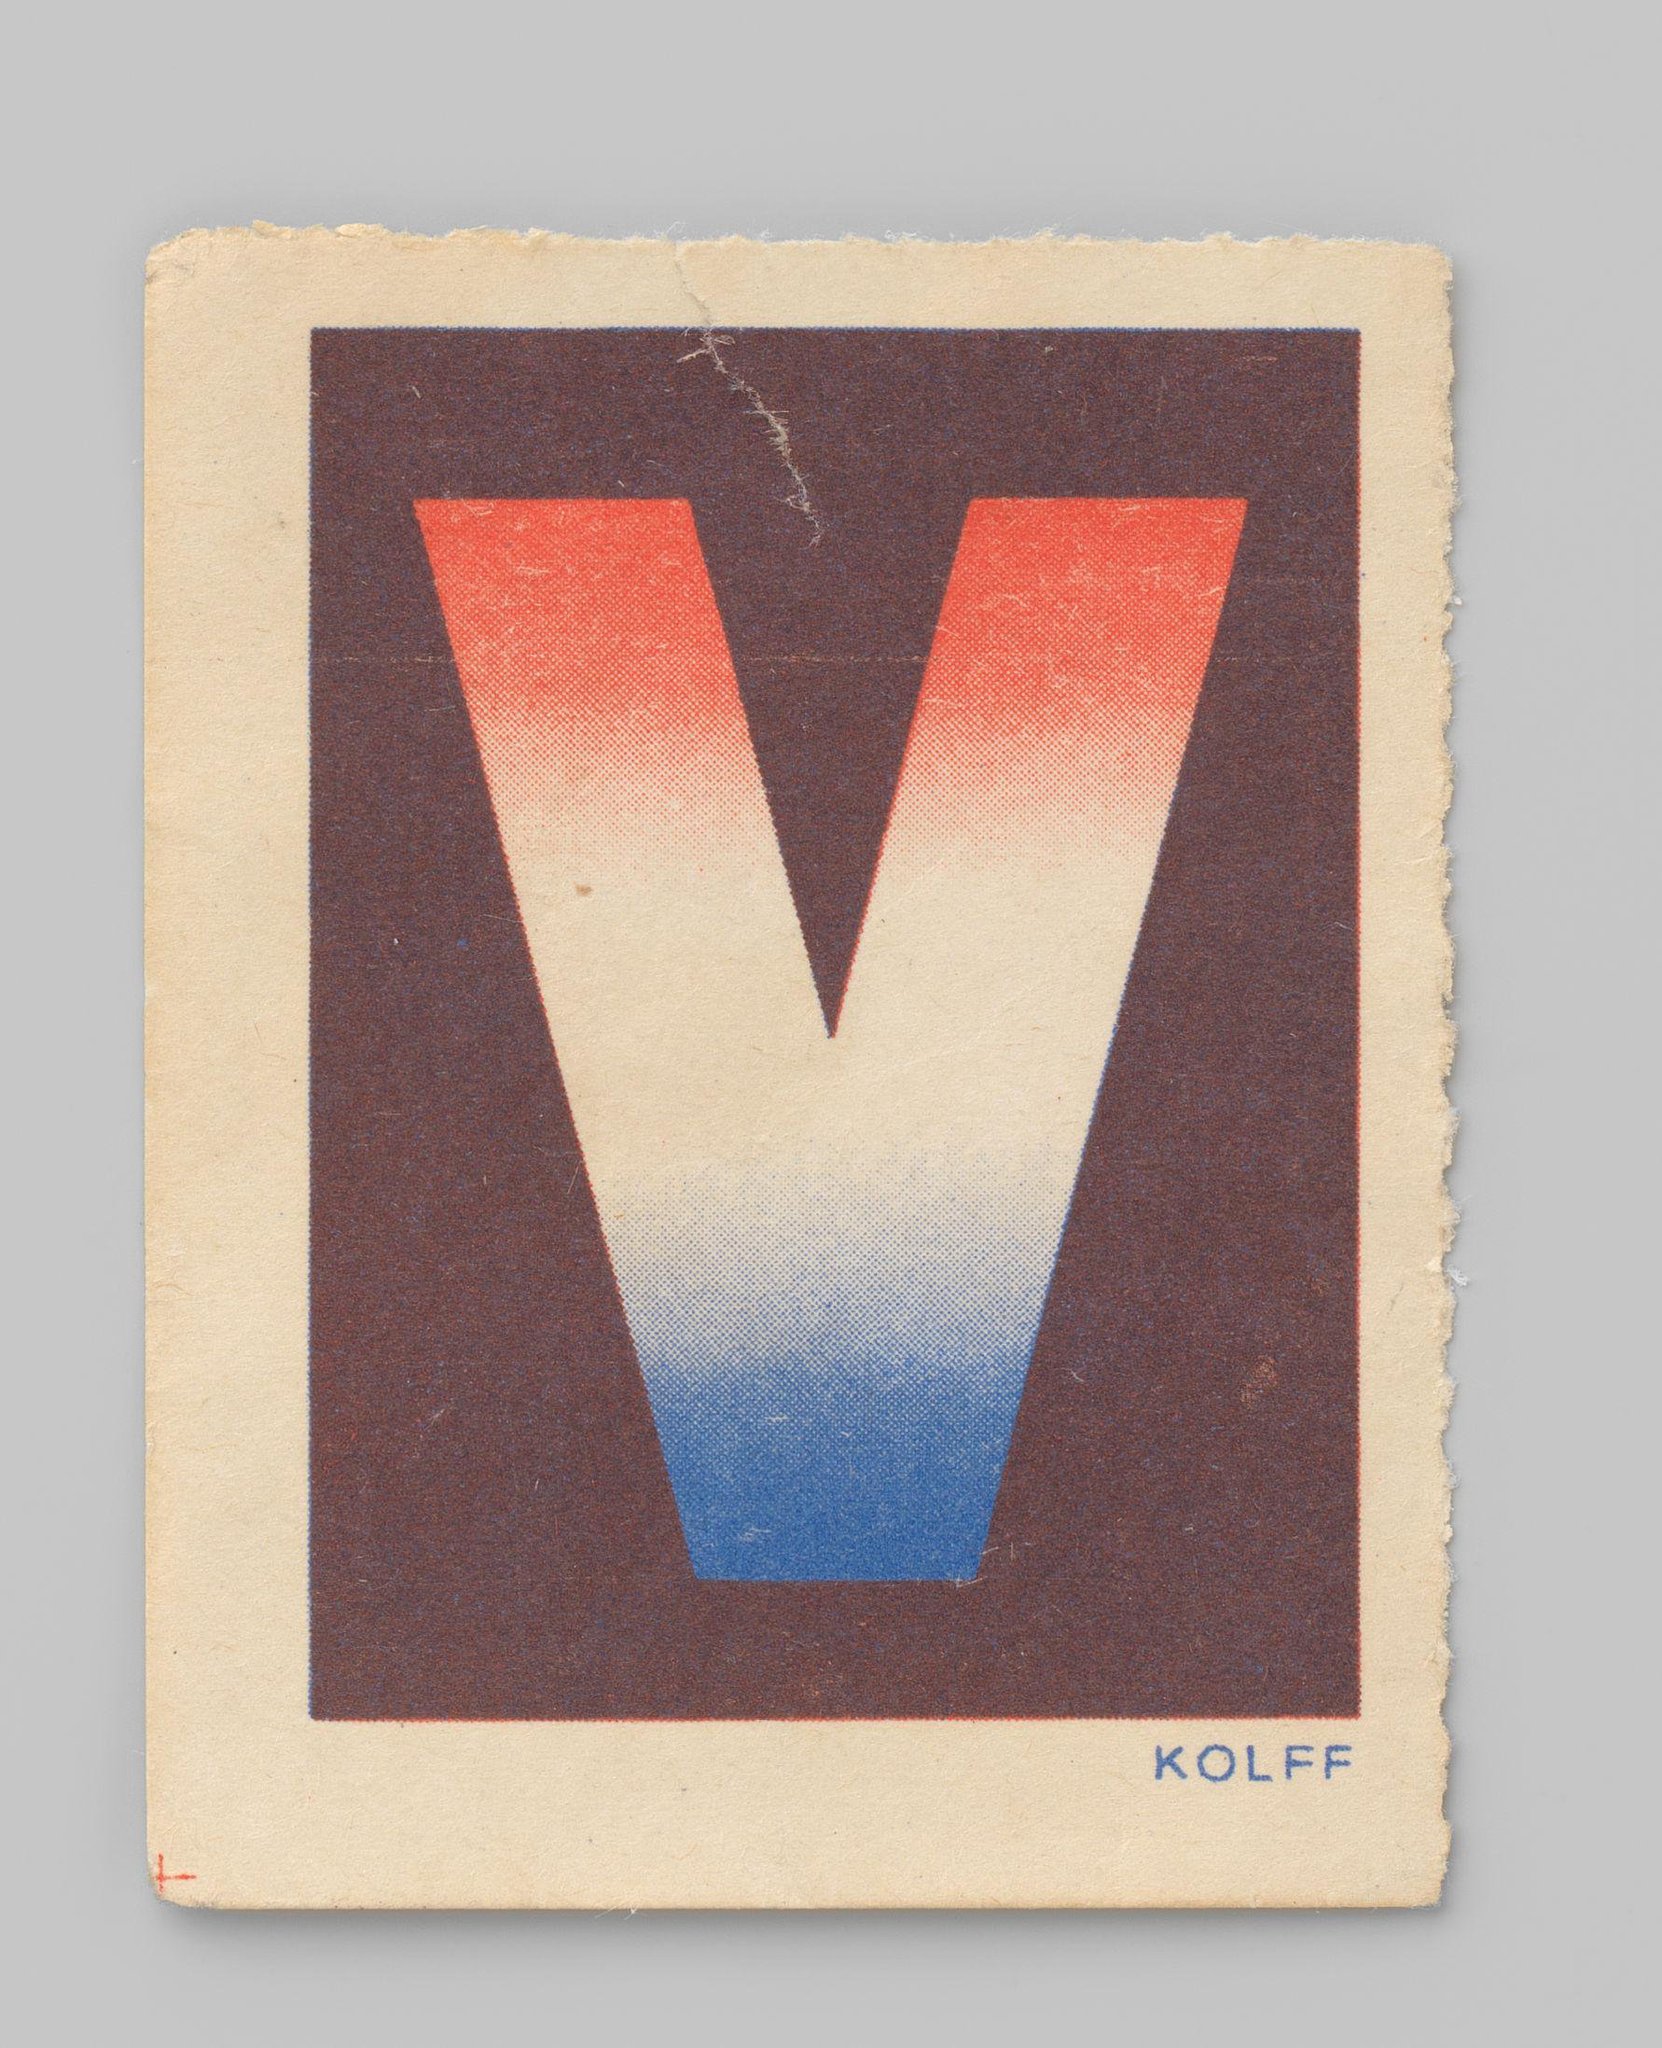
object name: sluitzegel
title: Plakzegel met V-teken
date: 1912-1941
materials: paper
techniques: printing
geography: batavia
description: "Plakzegel met V-teken; door de firma Kolff in Batavia gedrukt omstreeks december 1941." [Beschrijving Wim Schüller, Inventaris van de Grogoldoos, 1994/5]